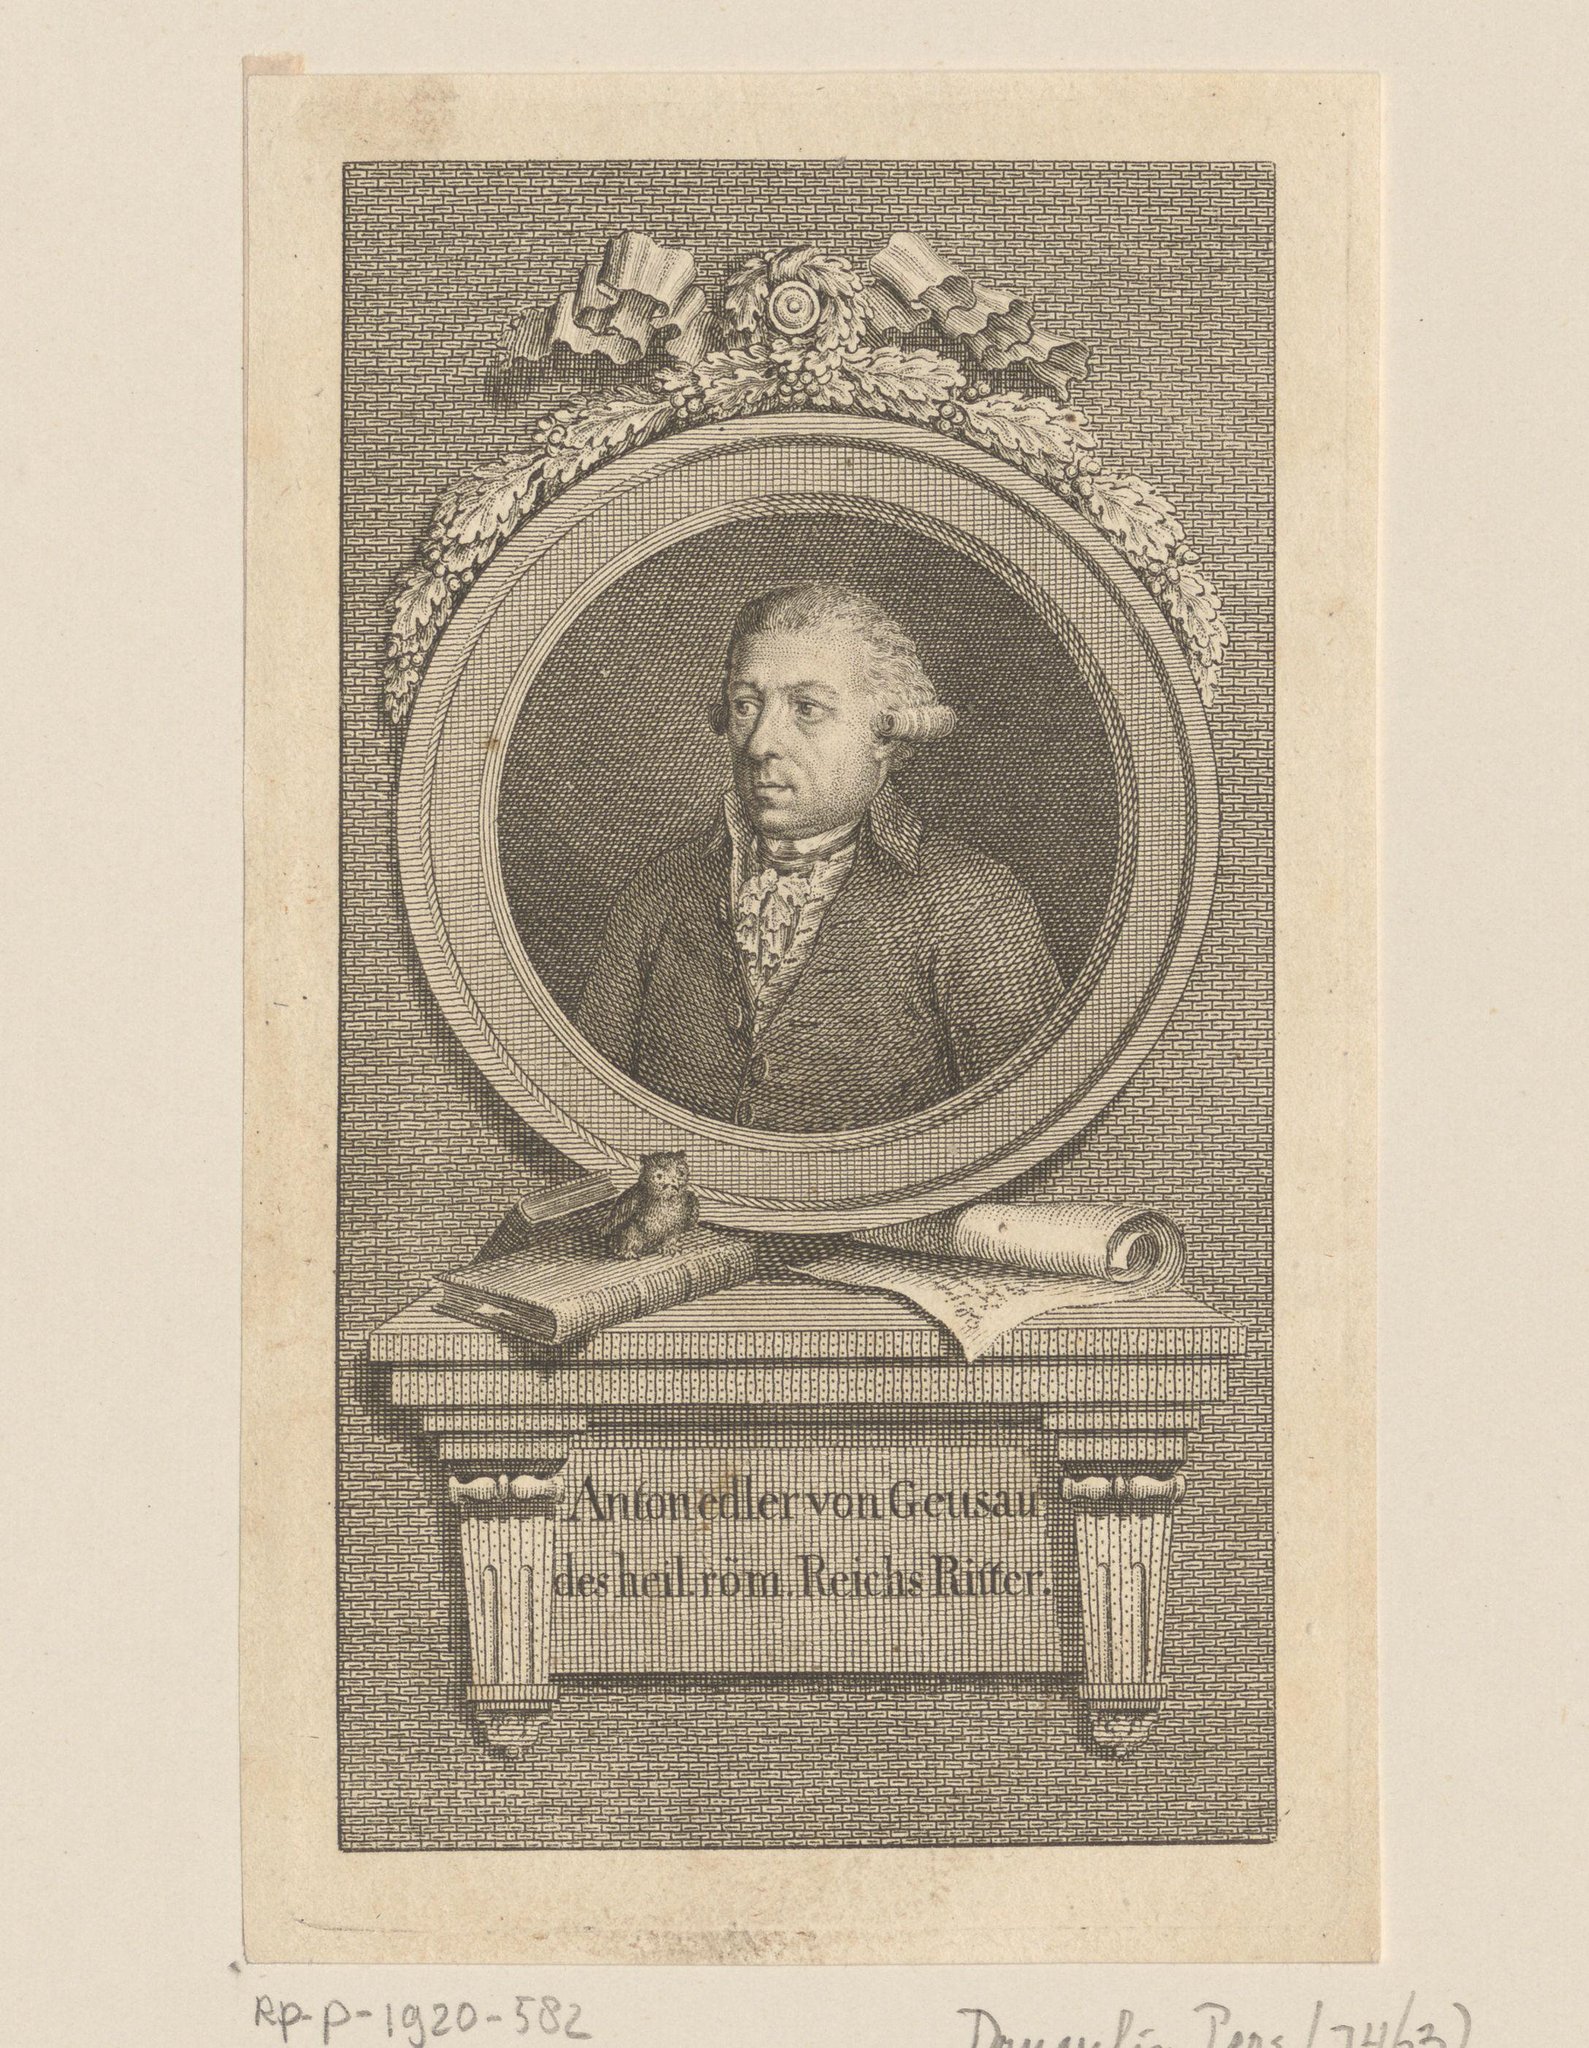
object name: print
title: Portret van Anton von Geusau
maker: Anonymous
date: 1710-1770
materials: paper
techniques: engraving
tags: historical persons, lawyer, attorney at law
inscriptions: collector's mark: Lugt 2228